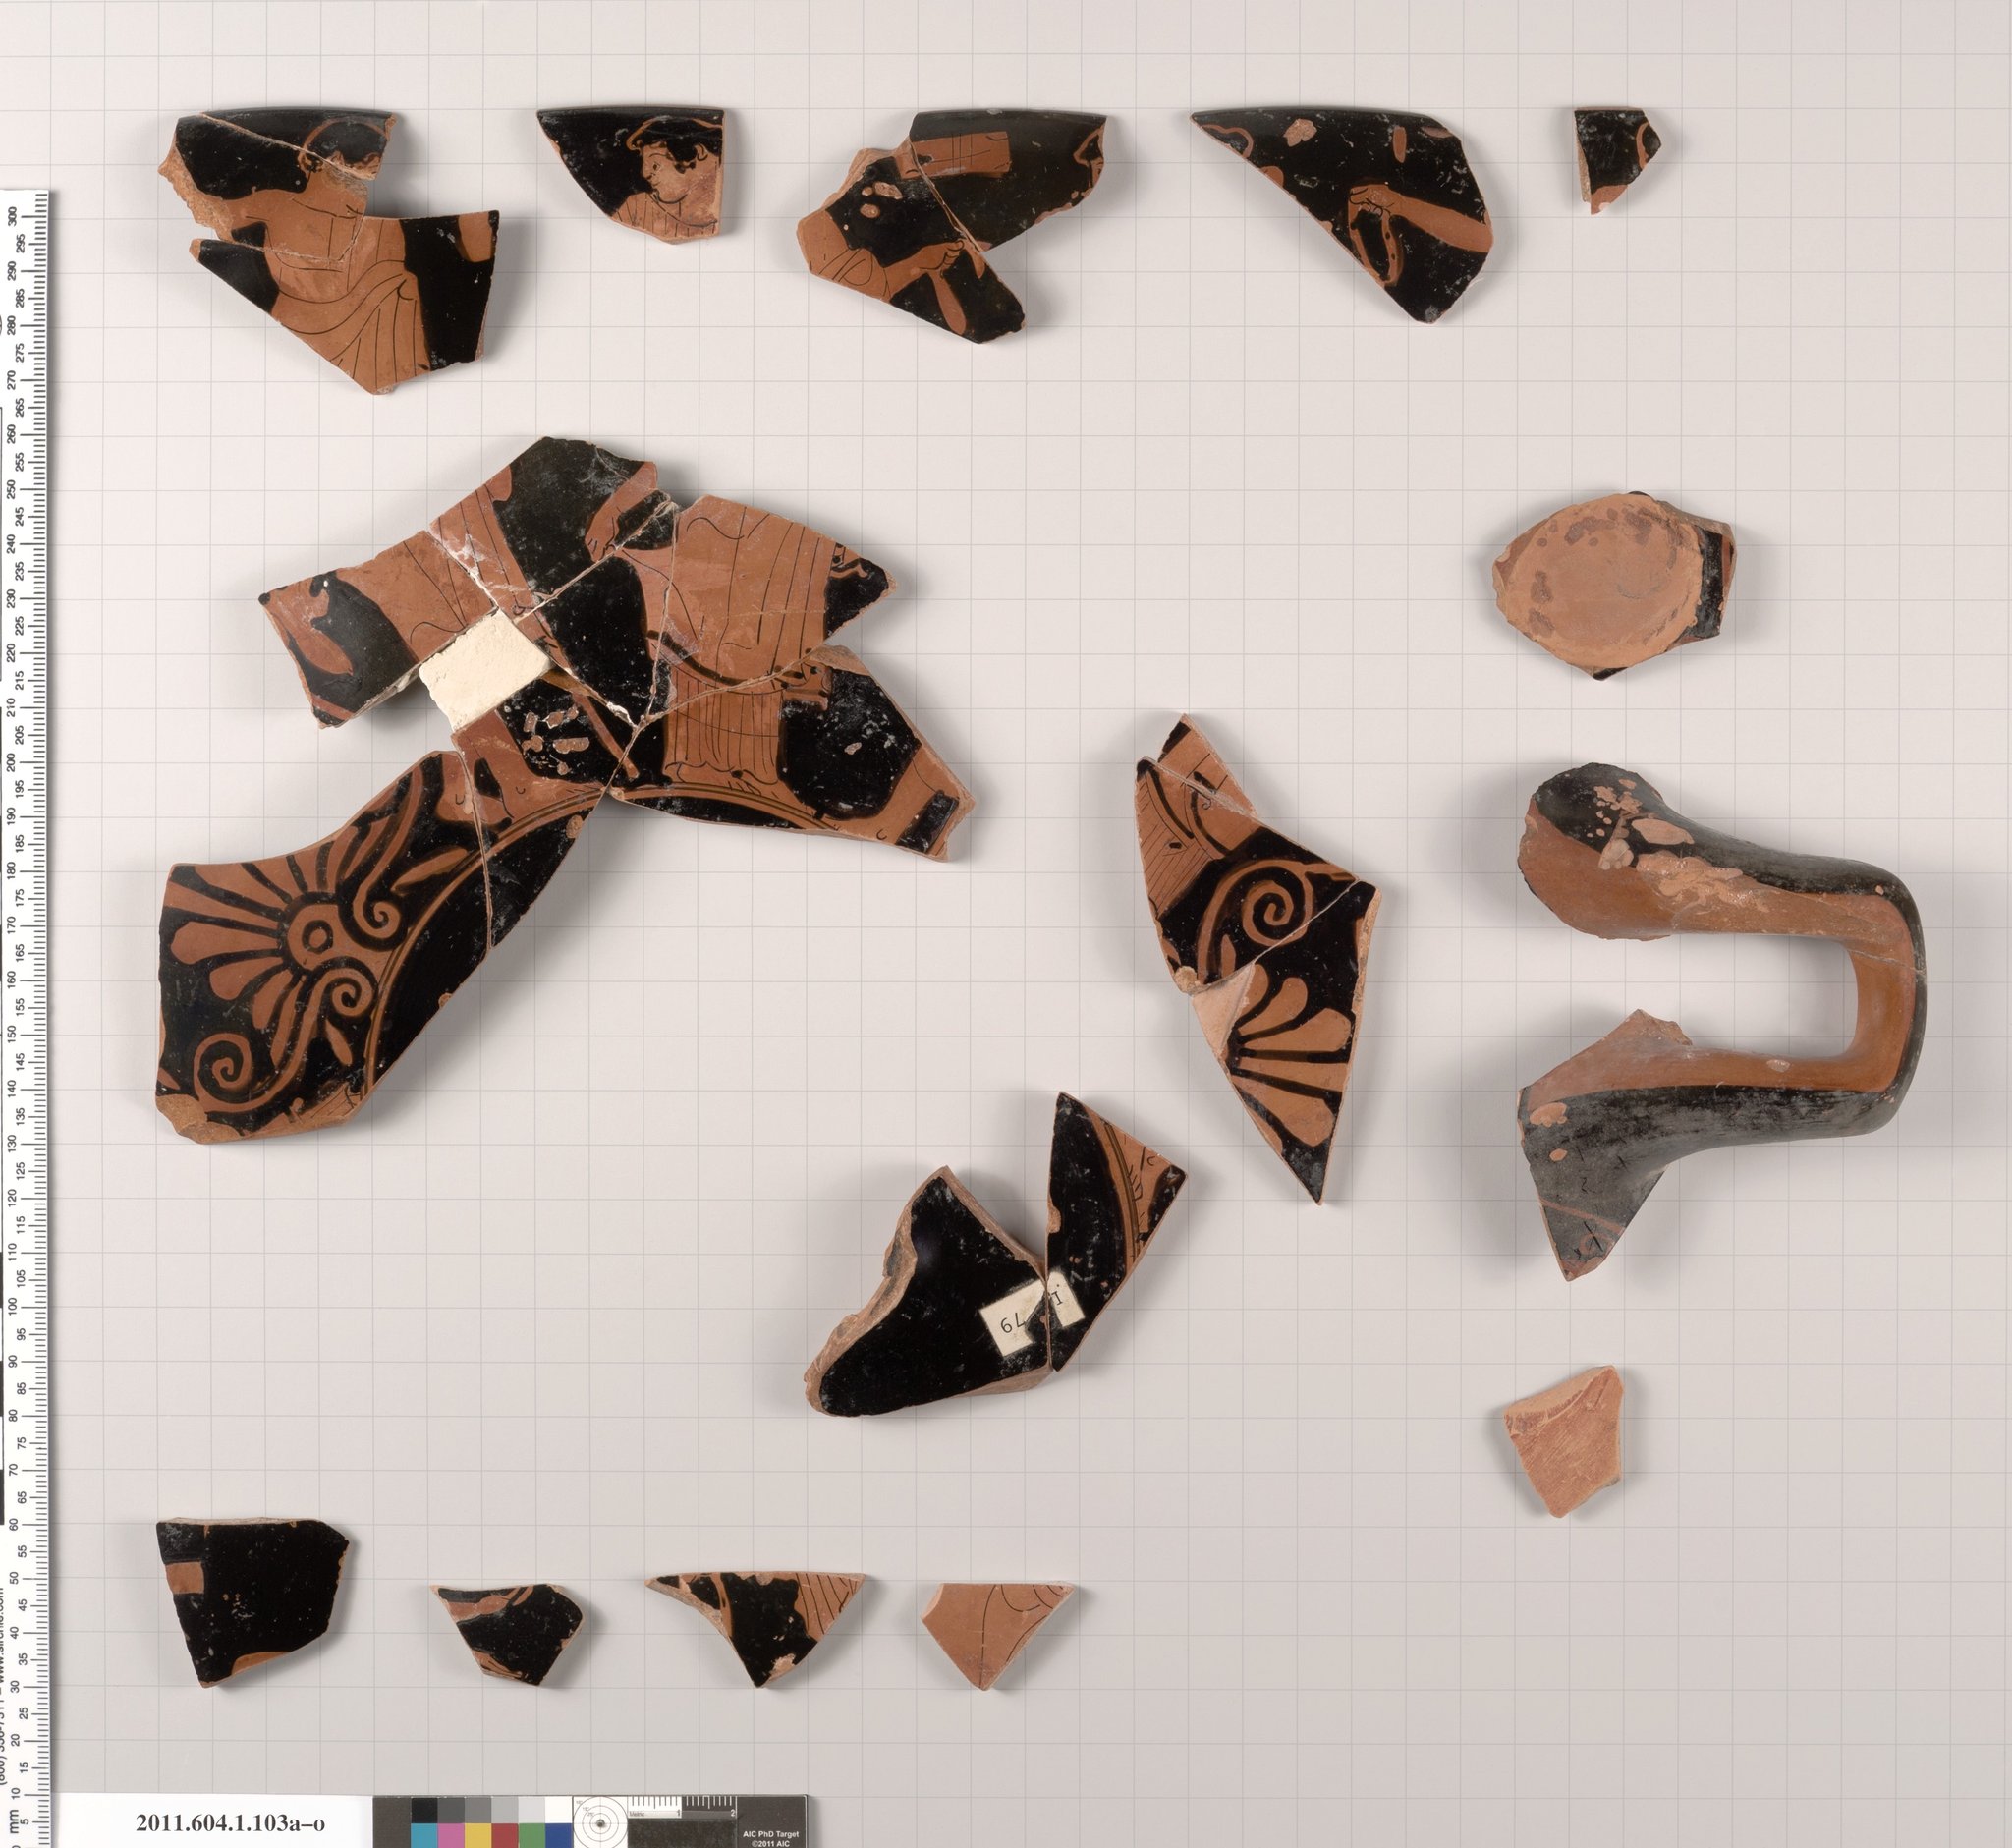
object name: kylix fragment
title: Terracotta fragments of a kylix (drinking cup)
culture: greek, attic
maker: splanchnopt painter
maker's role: artist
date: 470-450 BCE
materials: terracotta